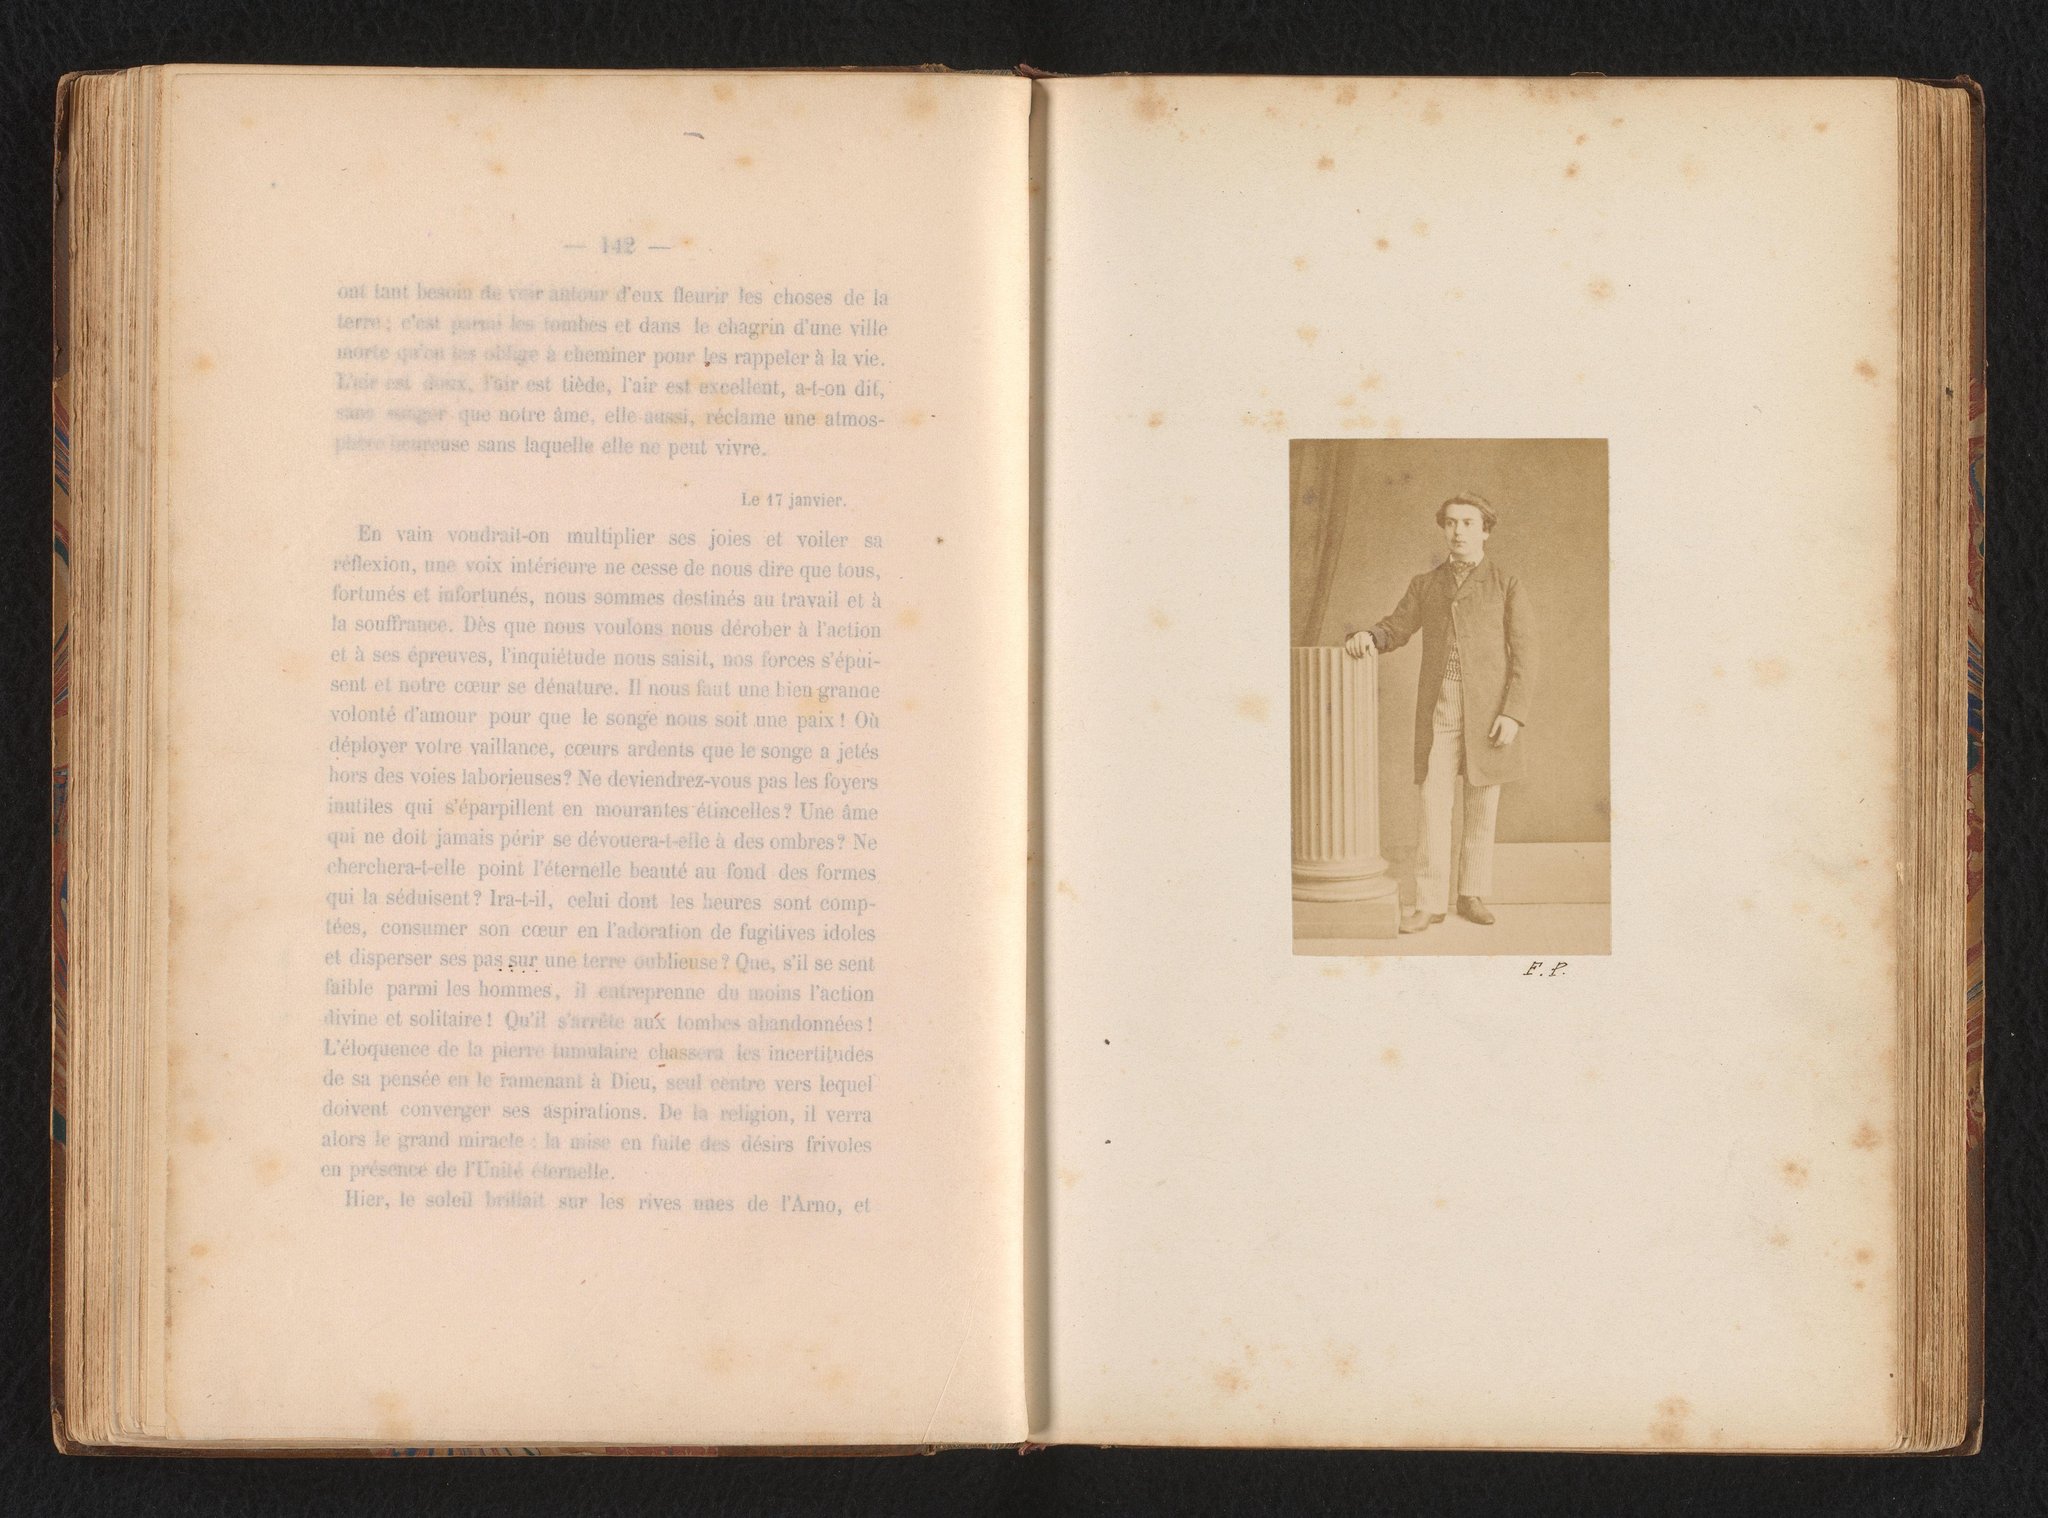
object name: page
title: Portret van een onbekende man, aangeduid als F.P.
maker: Anonymous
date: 1864-1869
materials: paper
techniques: albumen print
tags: adult man, historical persons